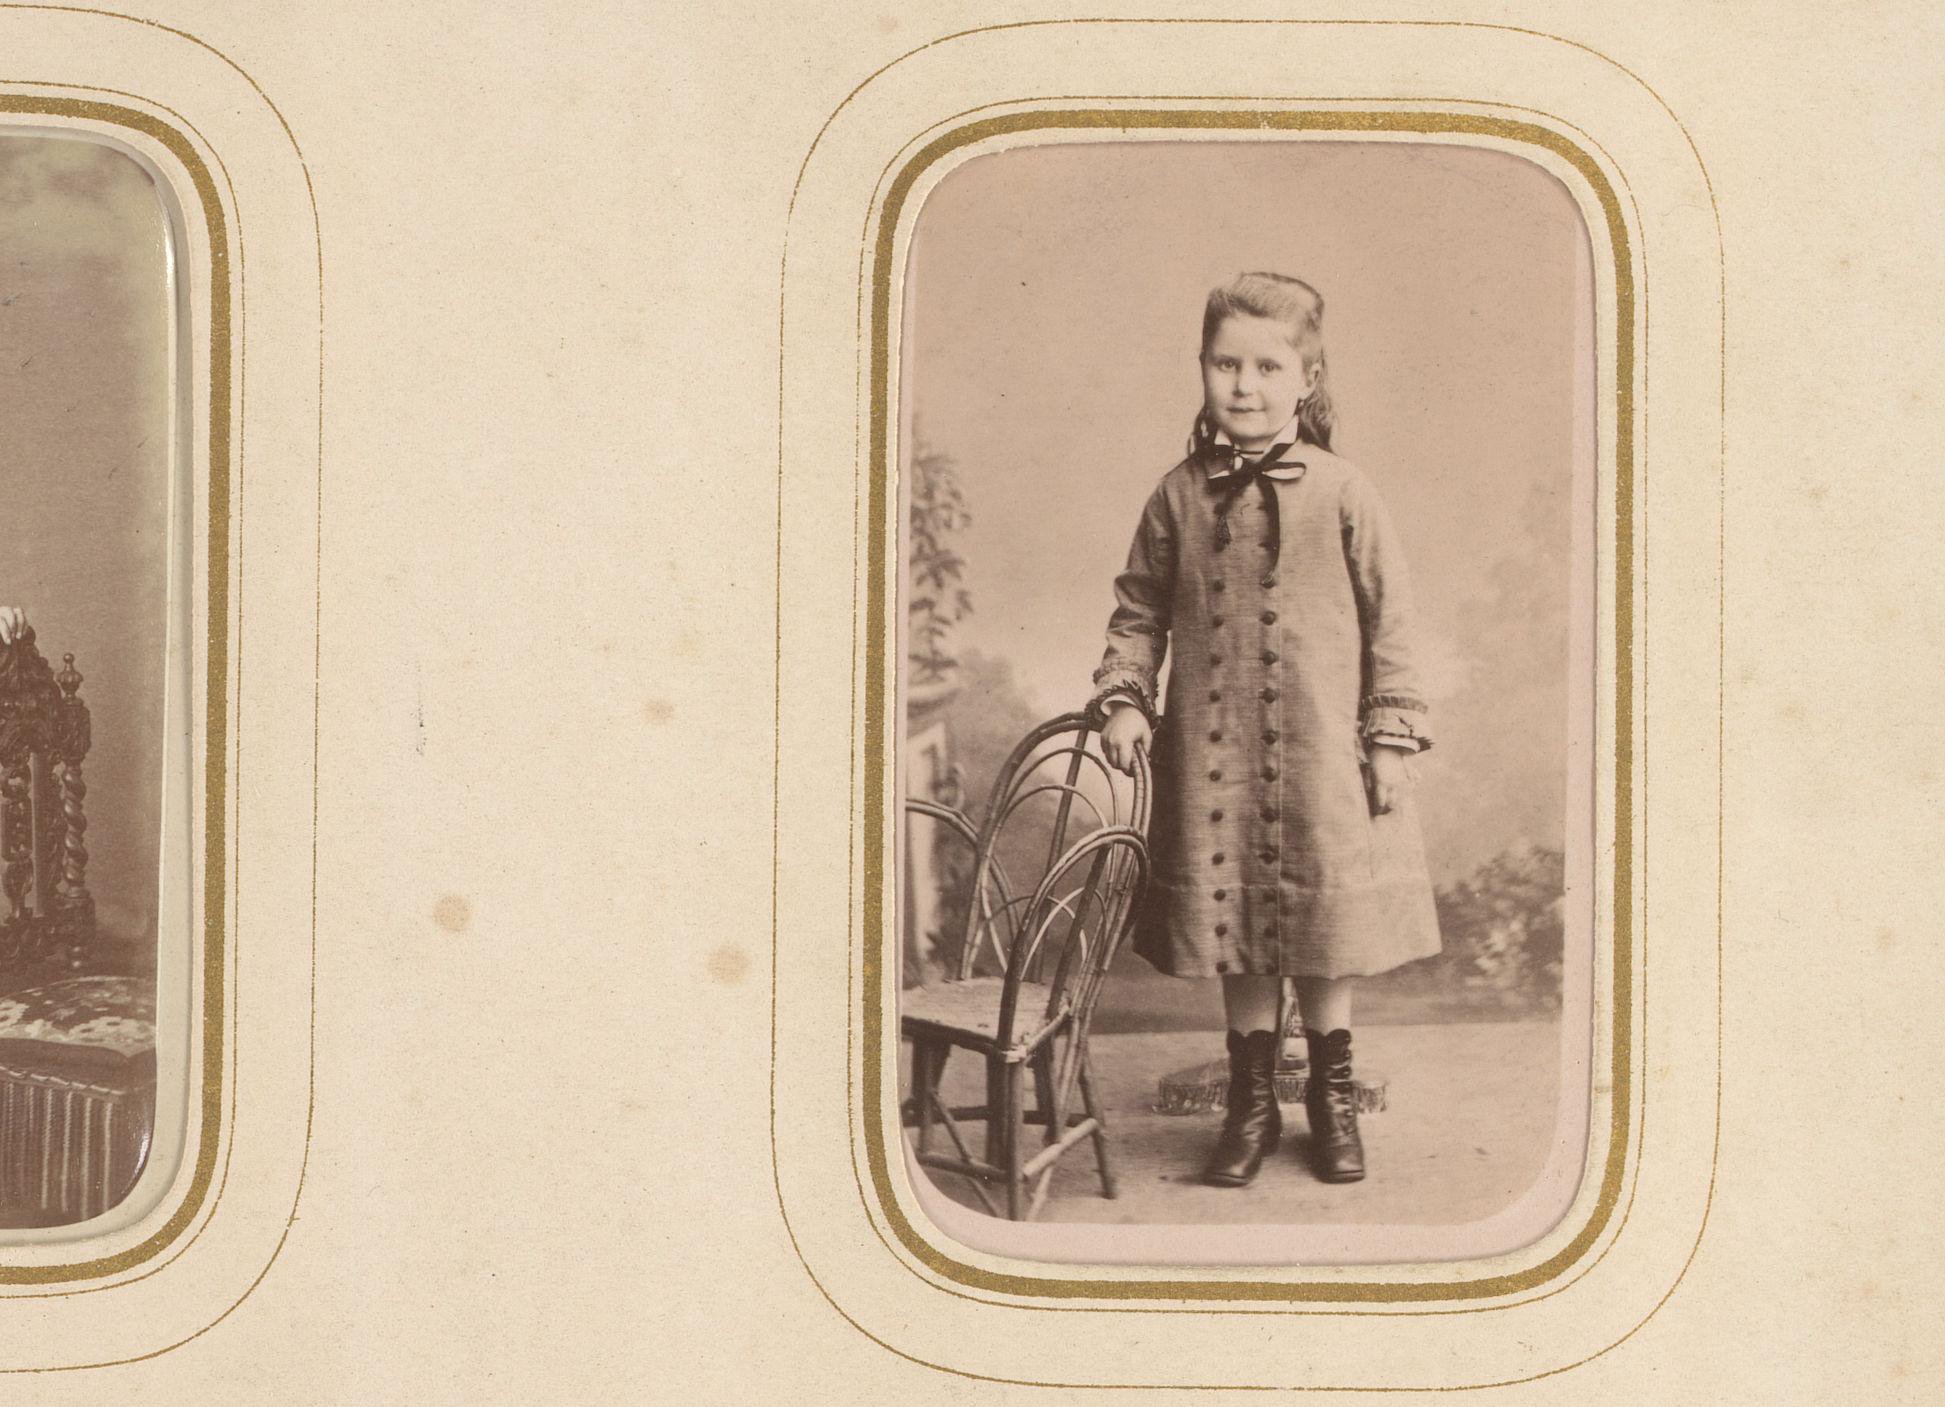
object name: carte de visite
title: Portret van een staand meisje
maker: léon duval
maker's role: fotograaf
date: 1880-1900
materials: cardboard, photographic support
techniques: albumen print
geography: soissons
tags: girl (child between toddler and youth)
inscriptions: inscription: ‘Léon Duval/ 14, Rue de la Buerie/ Près la Cathedrale/ Soissons’